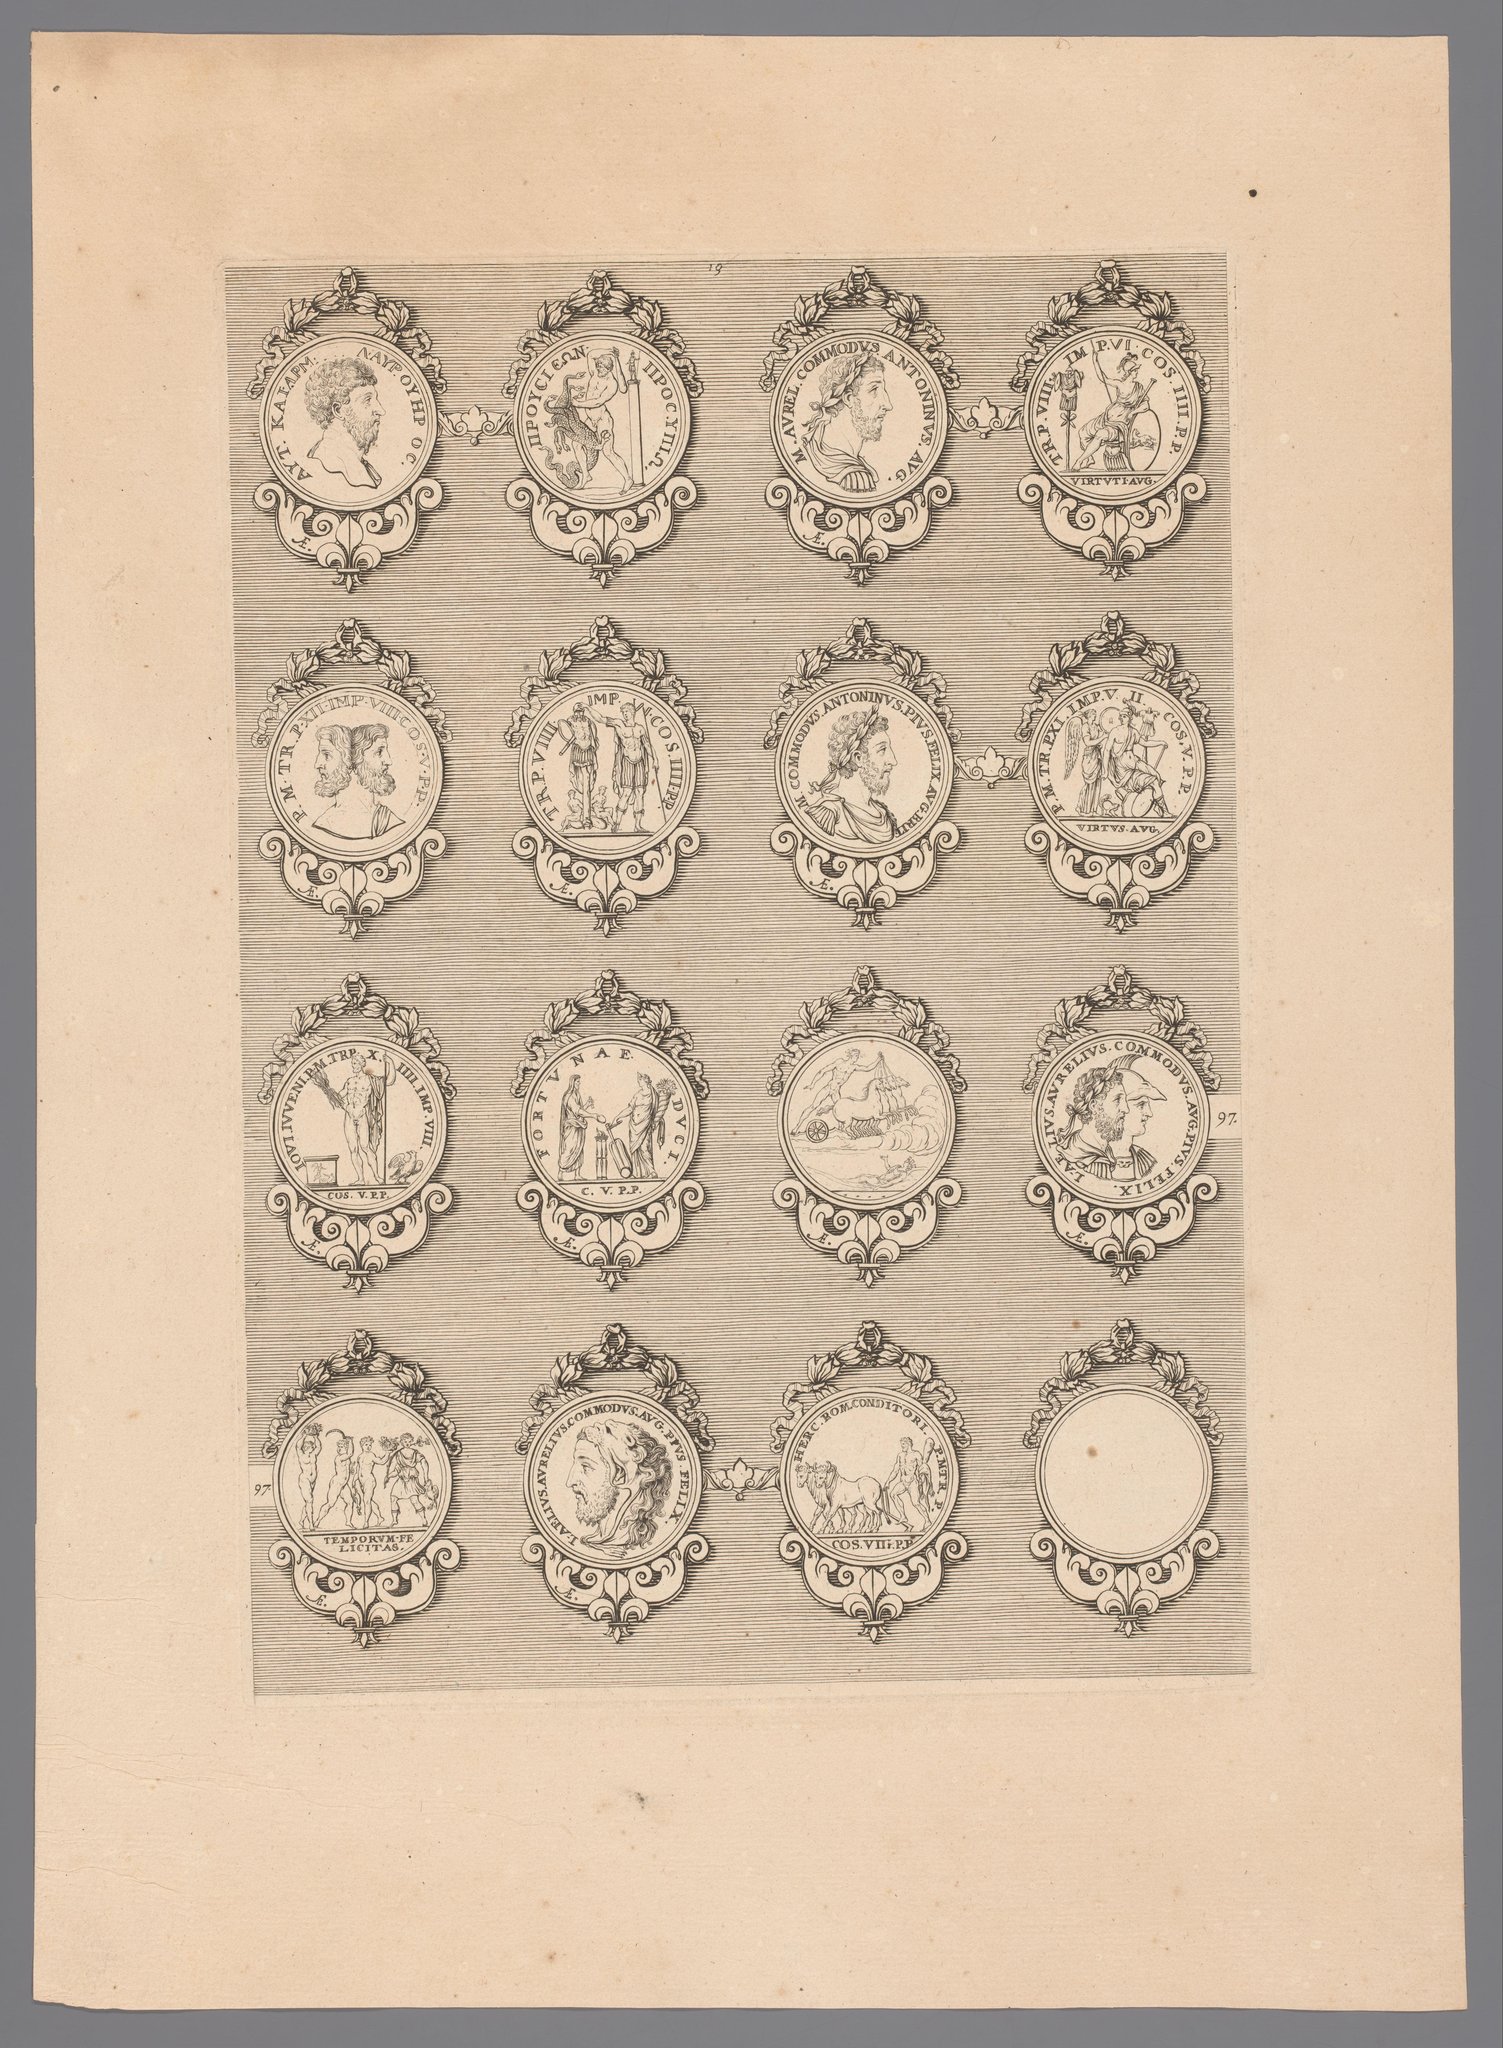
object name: print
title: Zestien penningen met versierde lijsten, waarvan één blanco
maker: simon de la boissière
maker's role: print maker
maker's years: 1637-1682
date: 1647-1682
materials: paper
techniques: etching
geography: france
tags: medal (considered as a piece of sculpture, regardless of its specific function)